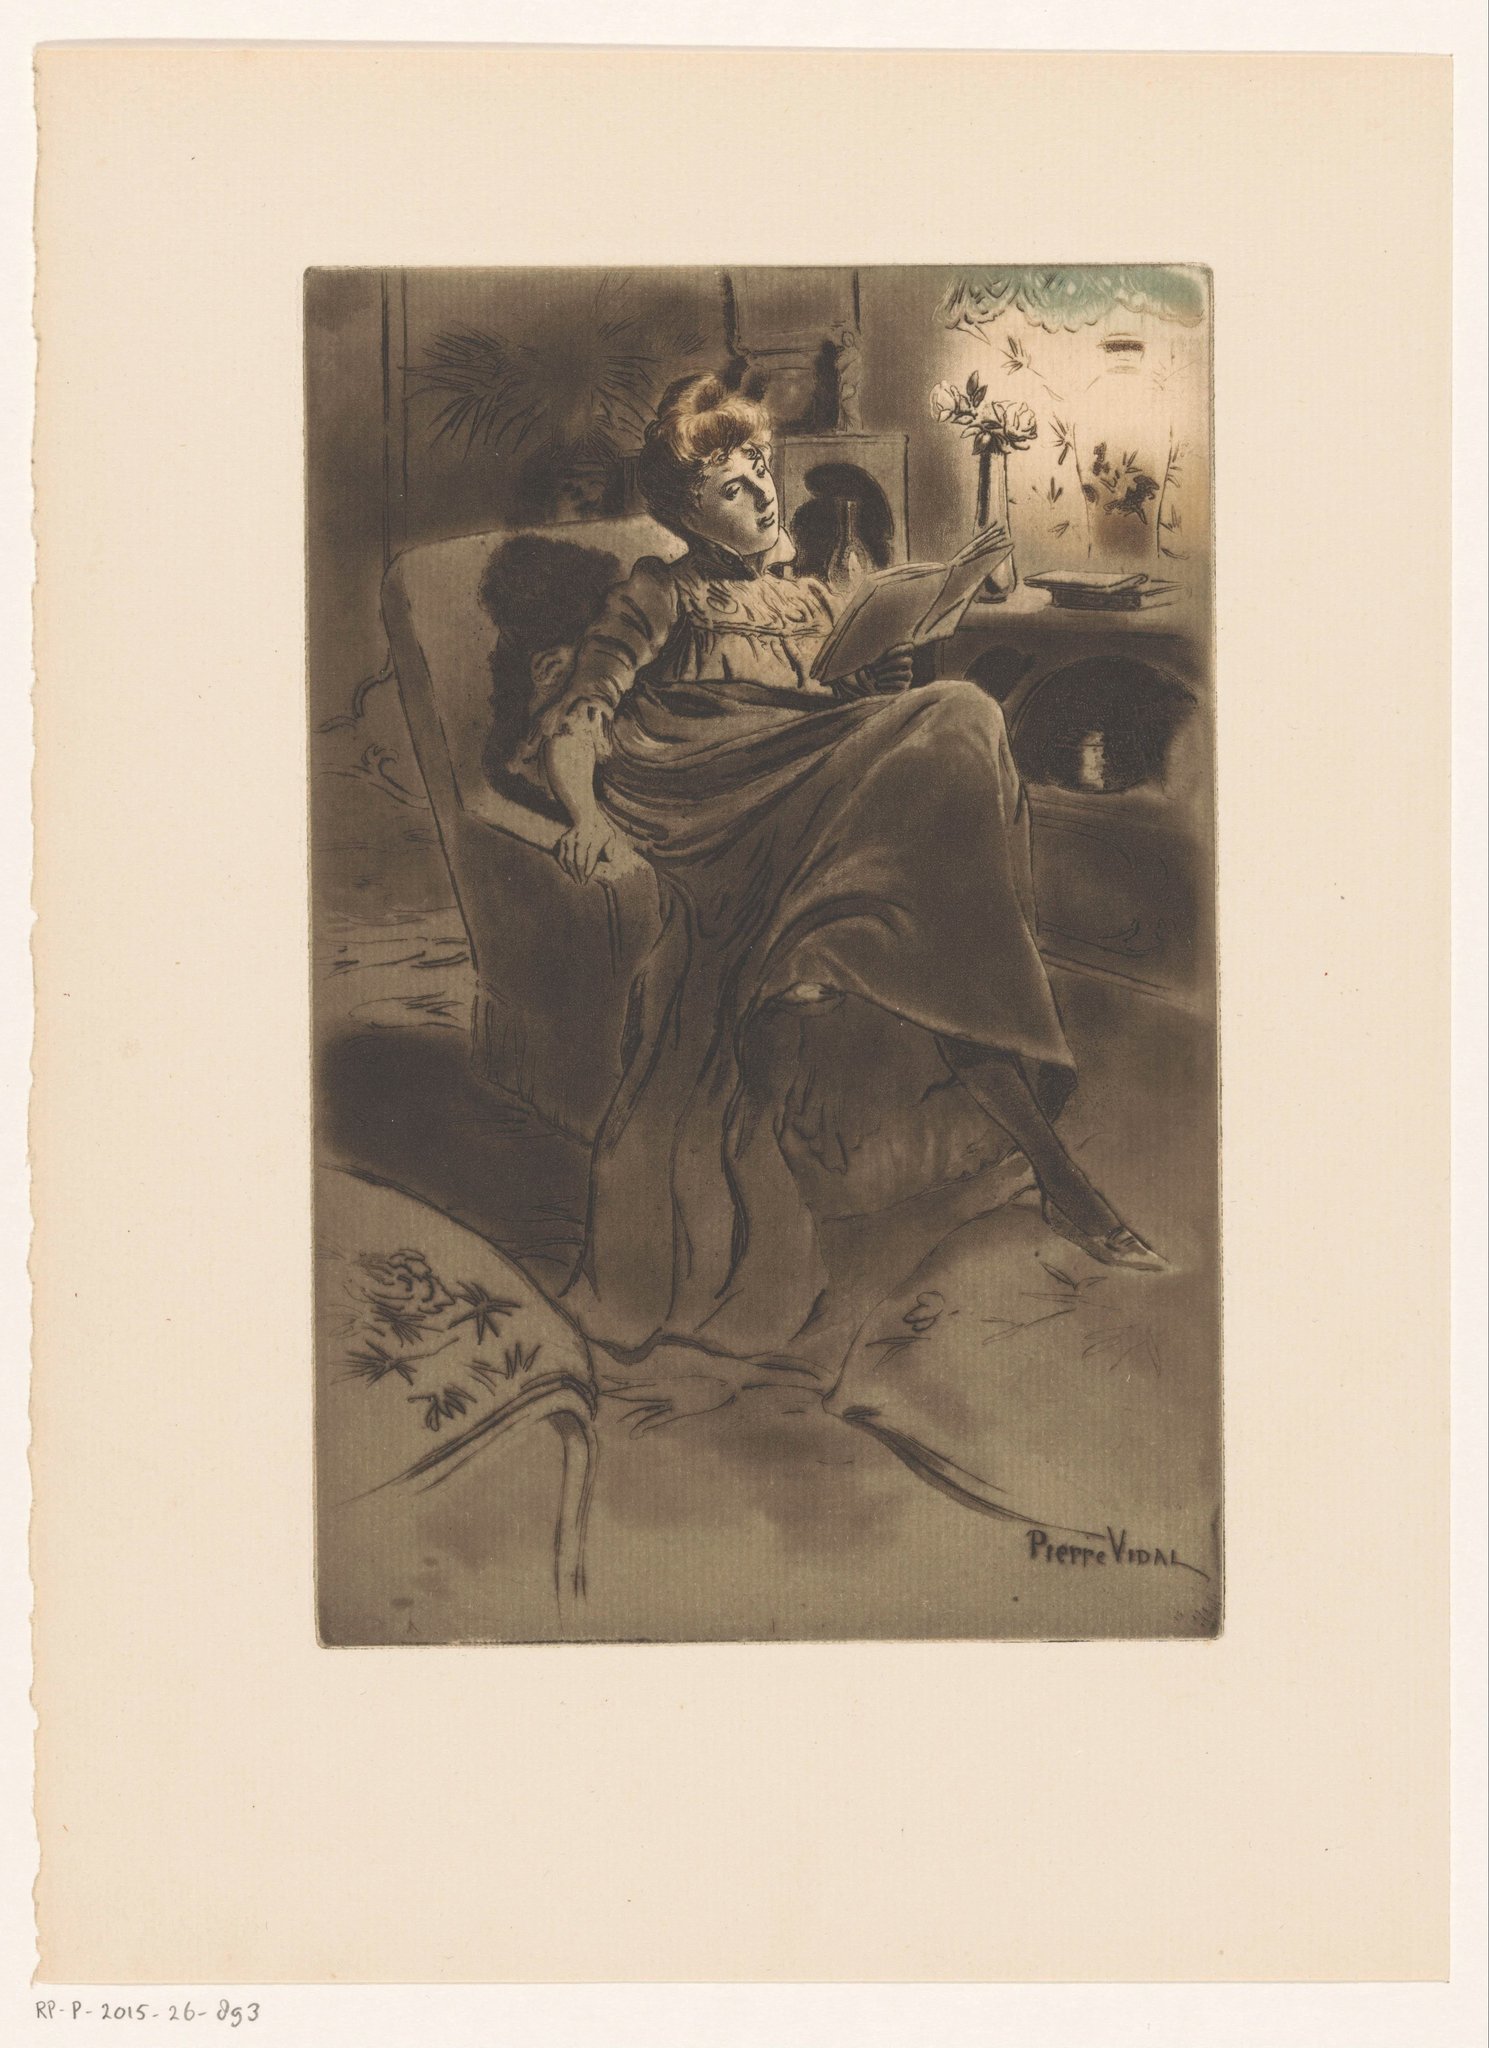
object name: print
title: Interieur met een lezende vrouw in een stoel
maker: pierre vidal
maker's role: draughtsman, print maker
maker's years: 1849-1929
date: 1859-1929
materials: paper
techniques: aquatint, drypoint, etching, intaglio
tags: newspaper, news-sheet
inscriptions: collector's mark, collector's mark: Lugt 2228